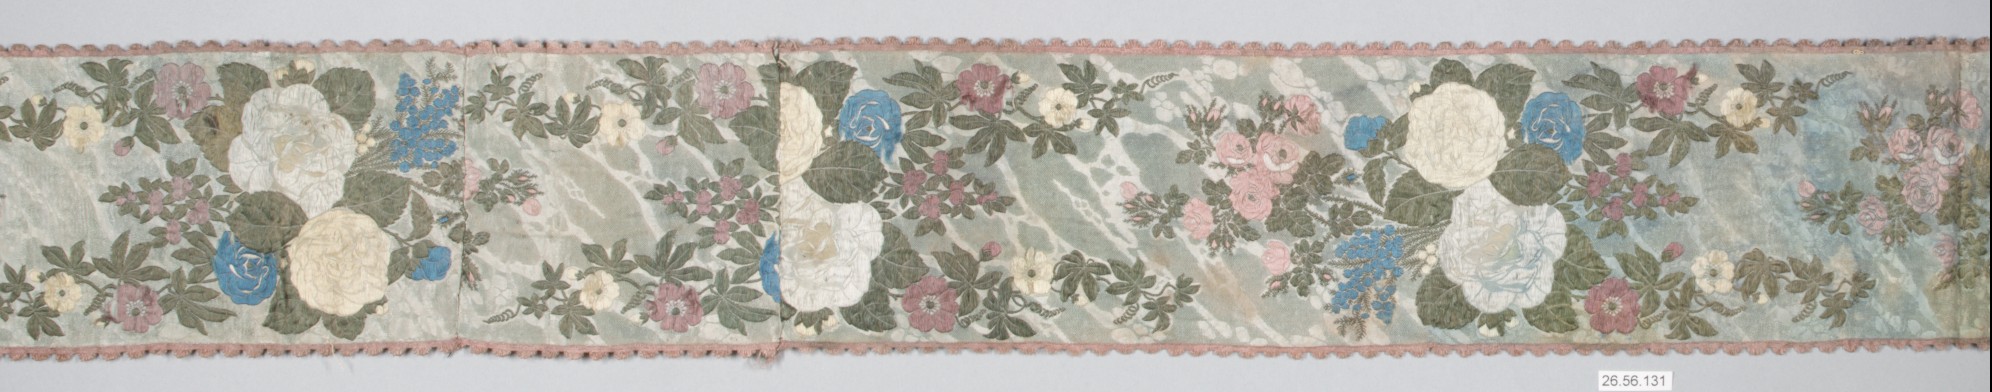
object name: ribbon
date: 1826-1850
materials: silk